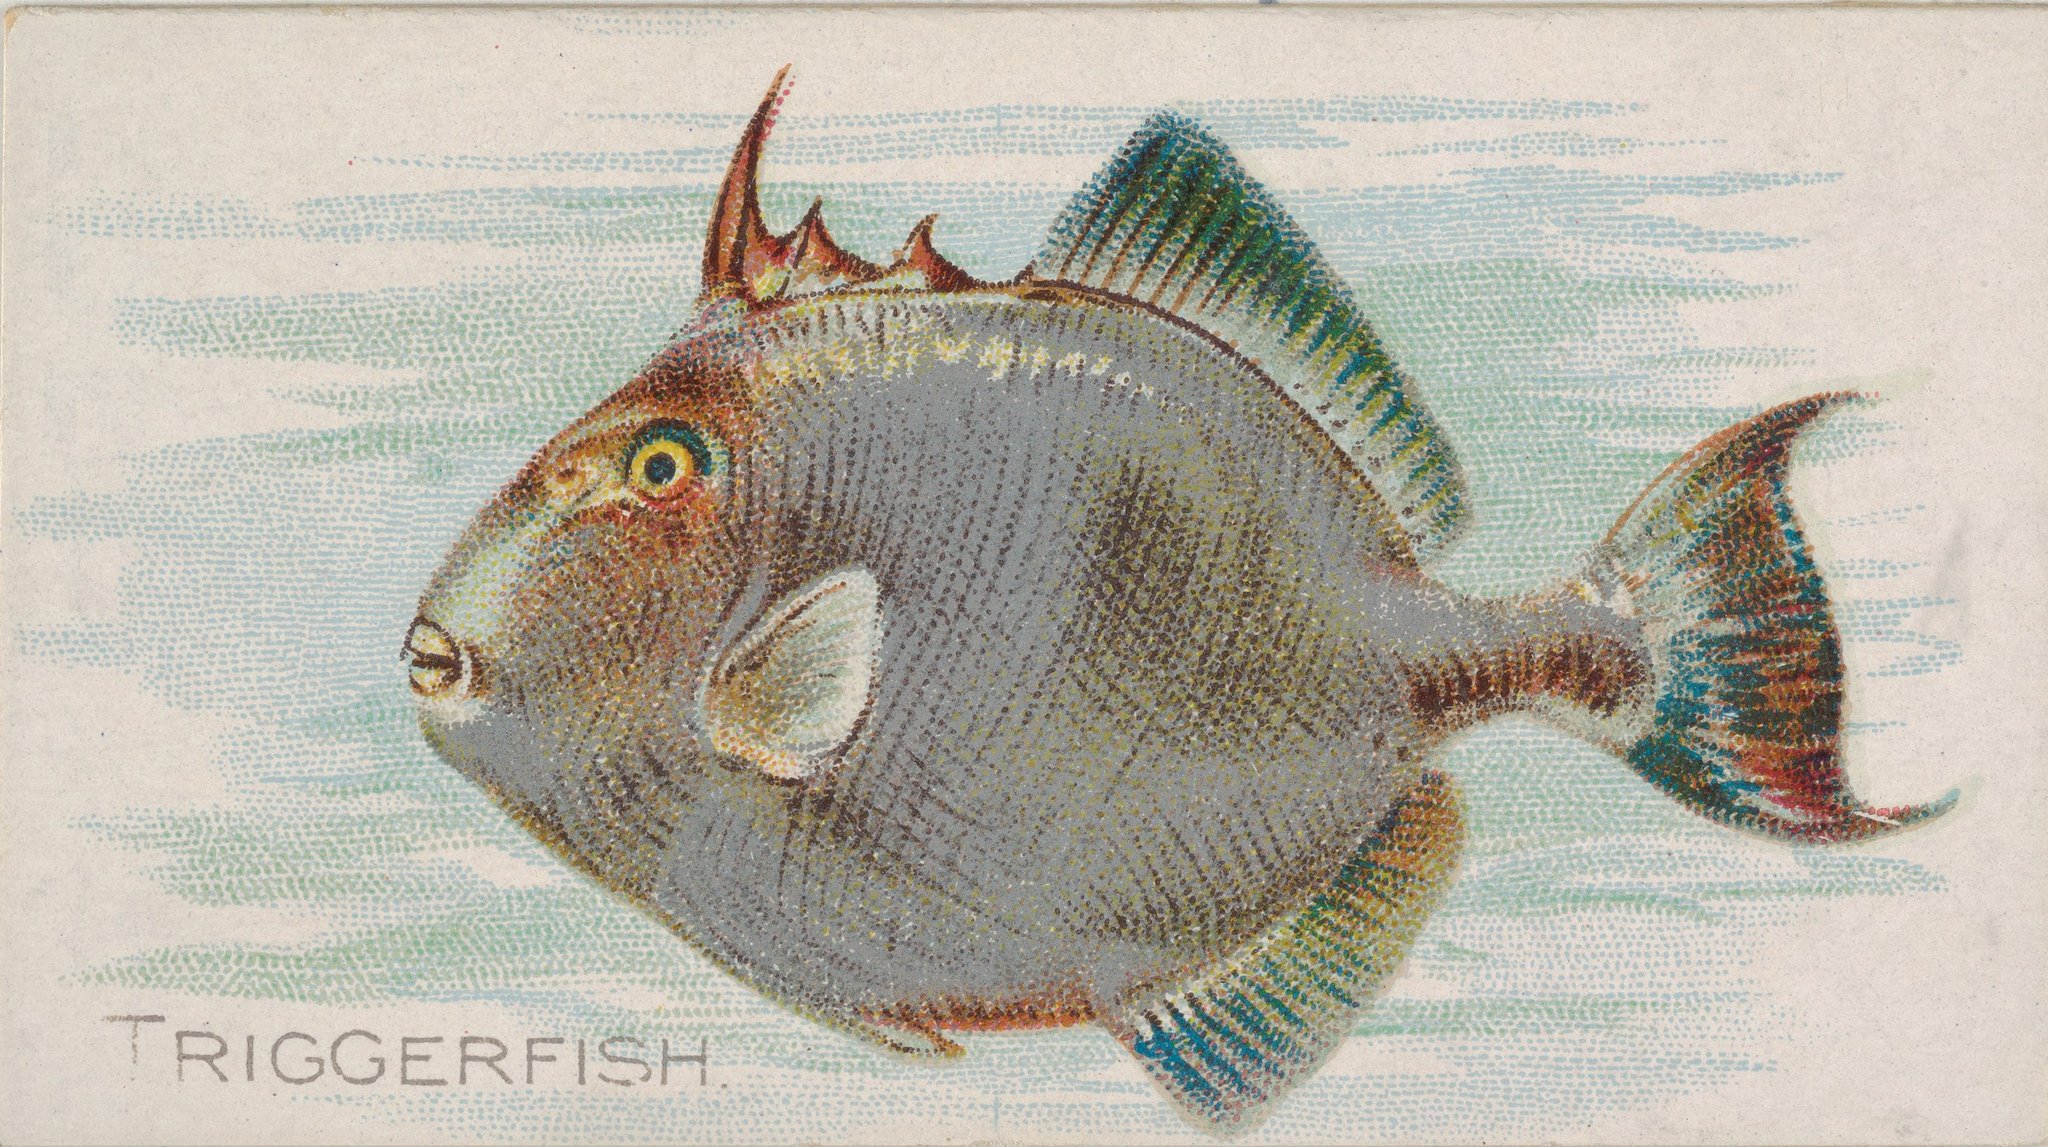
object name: print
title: Triggerfish, from the Fish from American Waters series (N8) for Allen & Ginter Cigarettes Brands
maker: allen & ginter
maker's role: publisher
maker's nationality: american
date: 1889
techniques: color lithograph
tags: fish